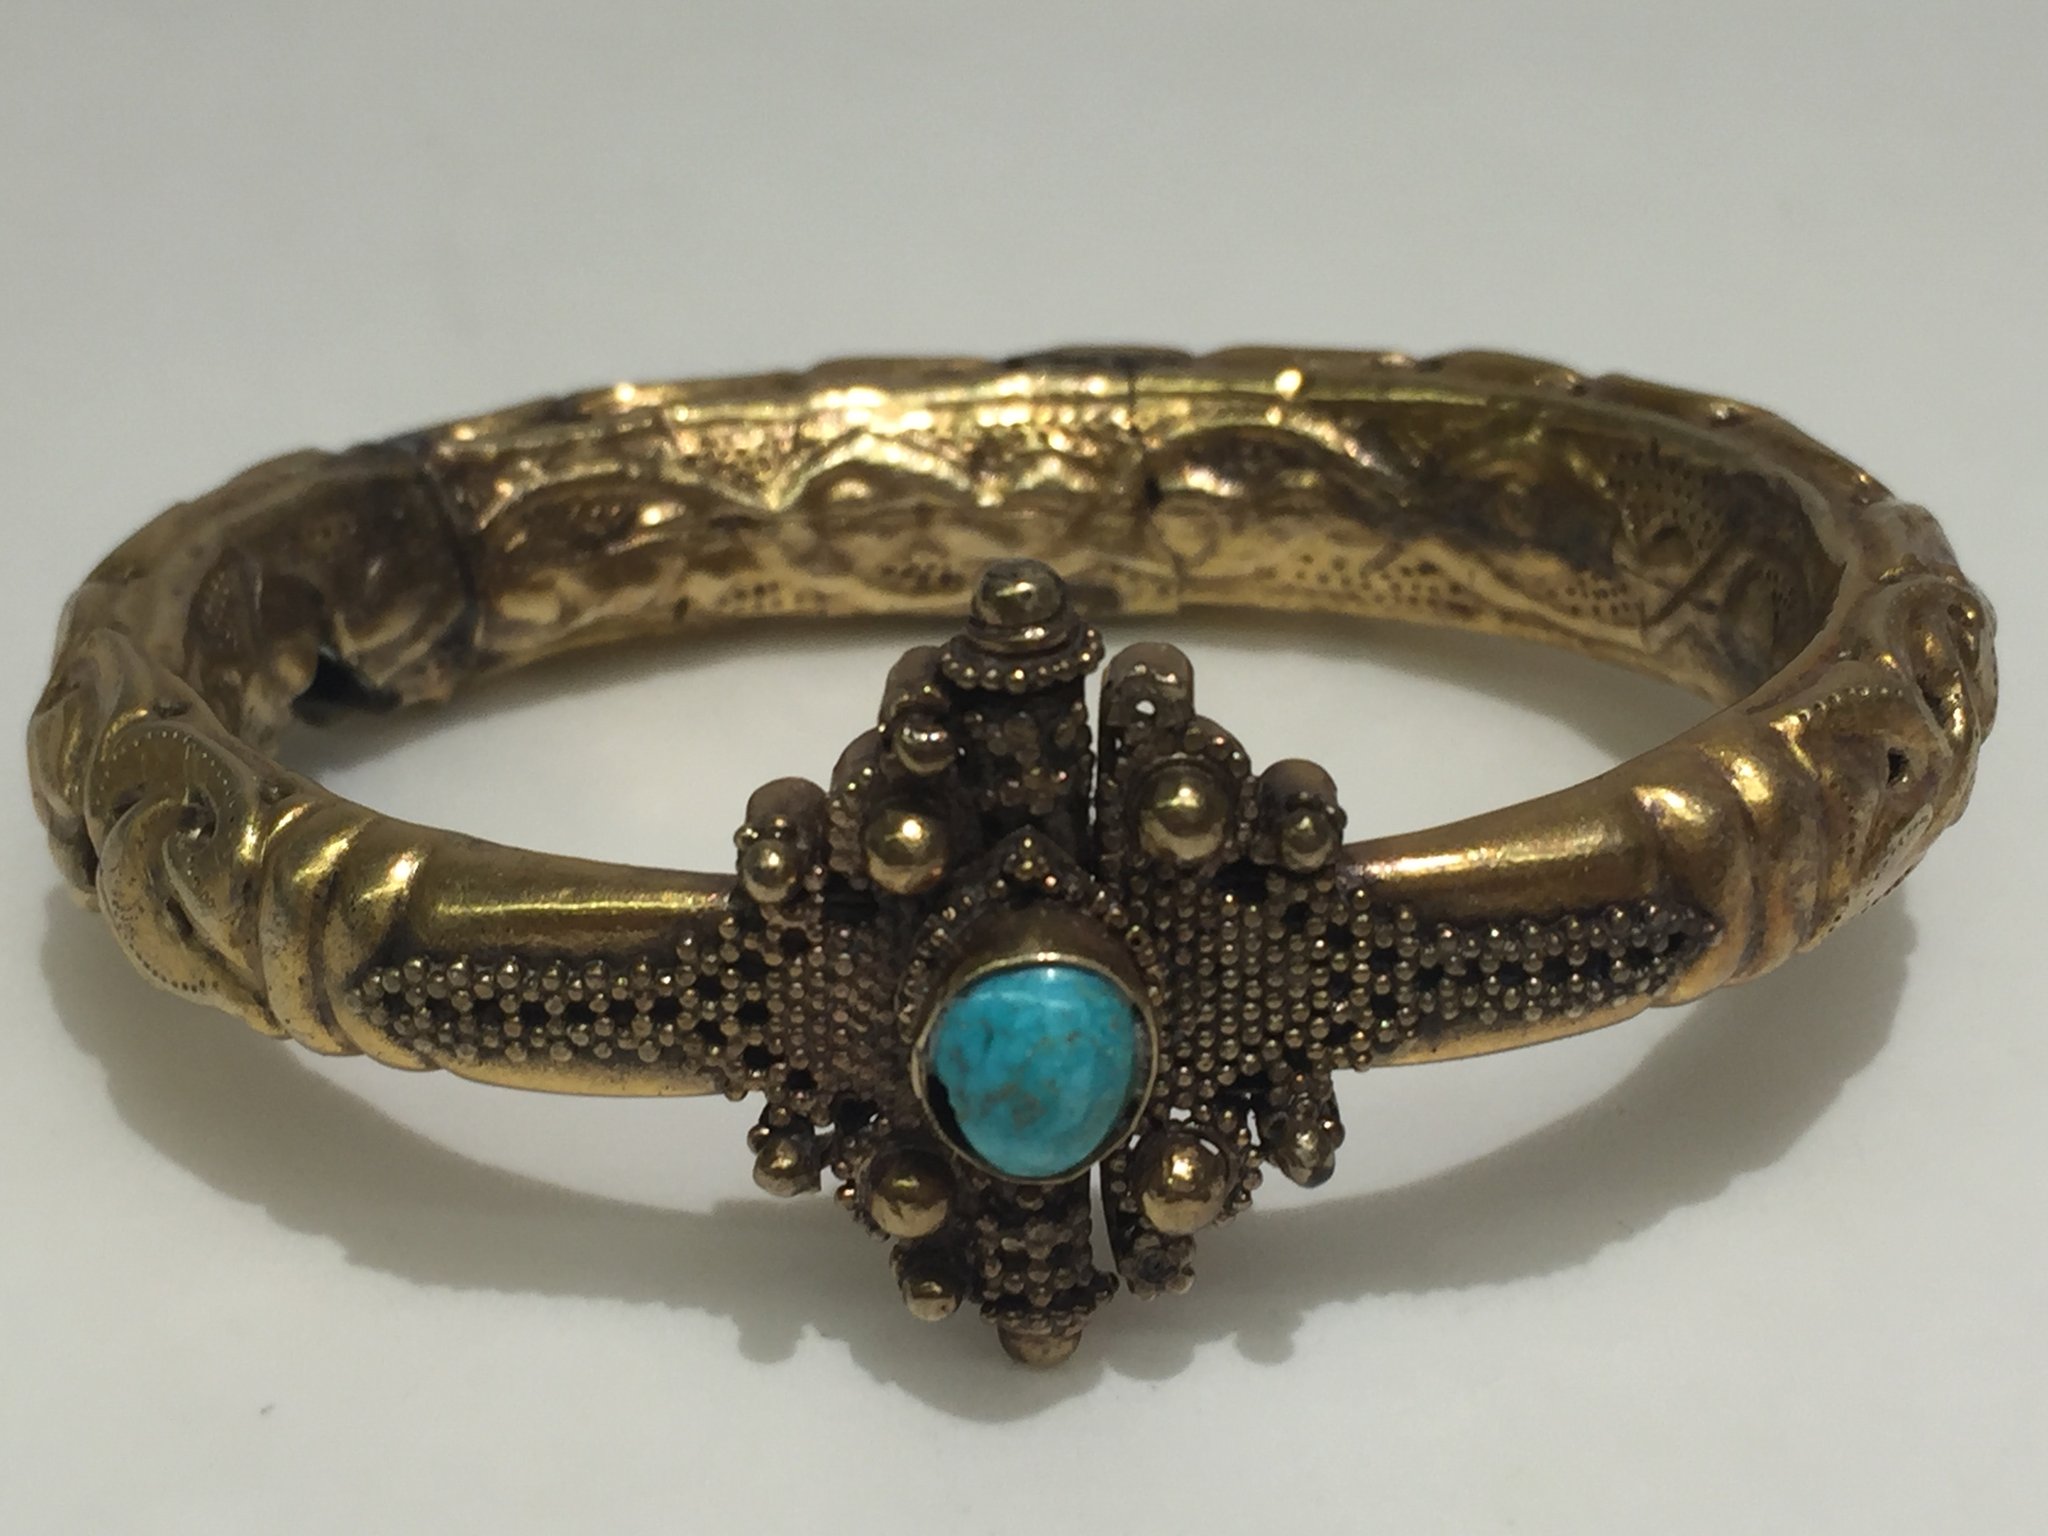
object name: bracelet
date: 1001-1200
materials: gold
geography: syria